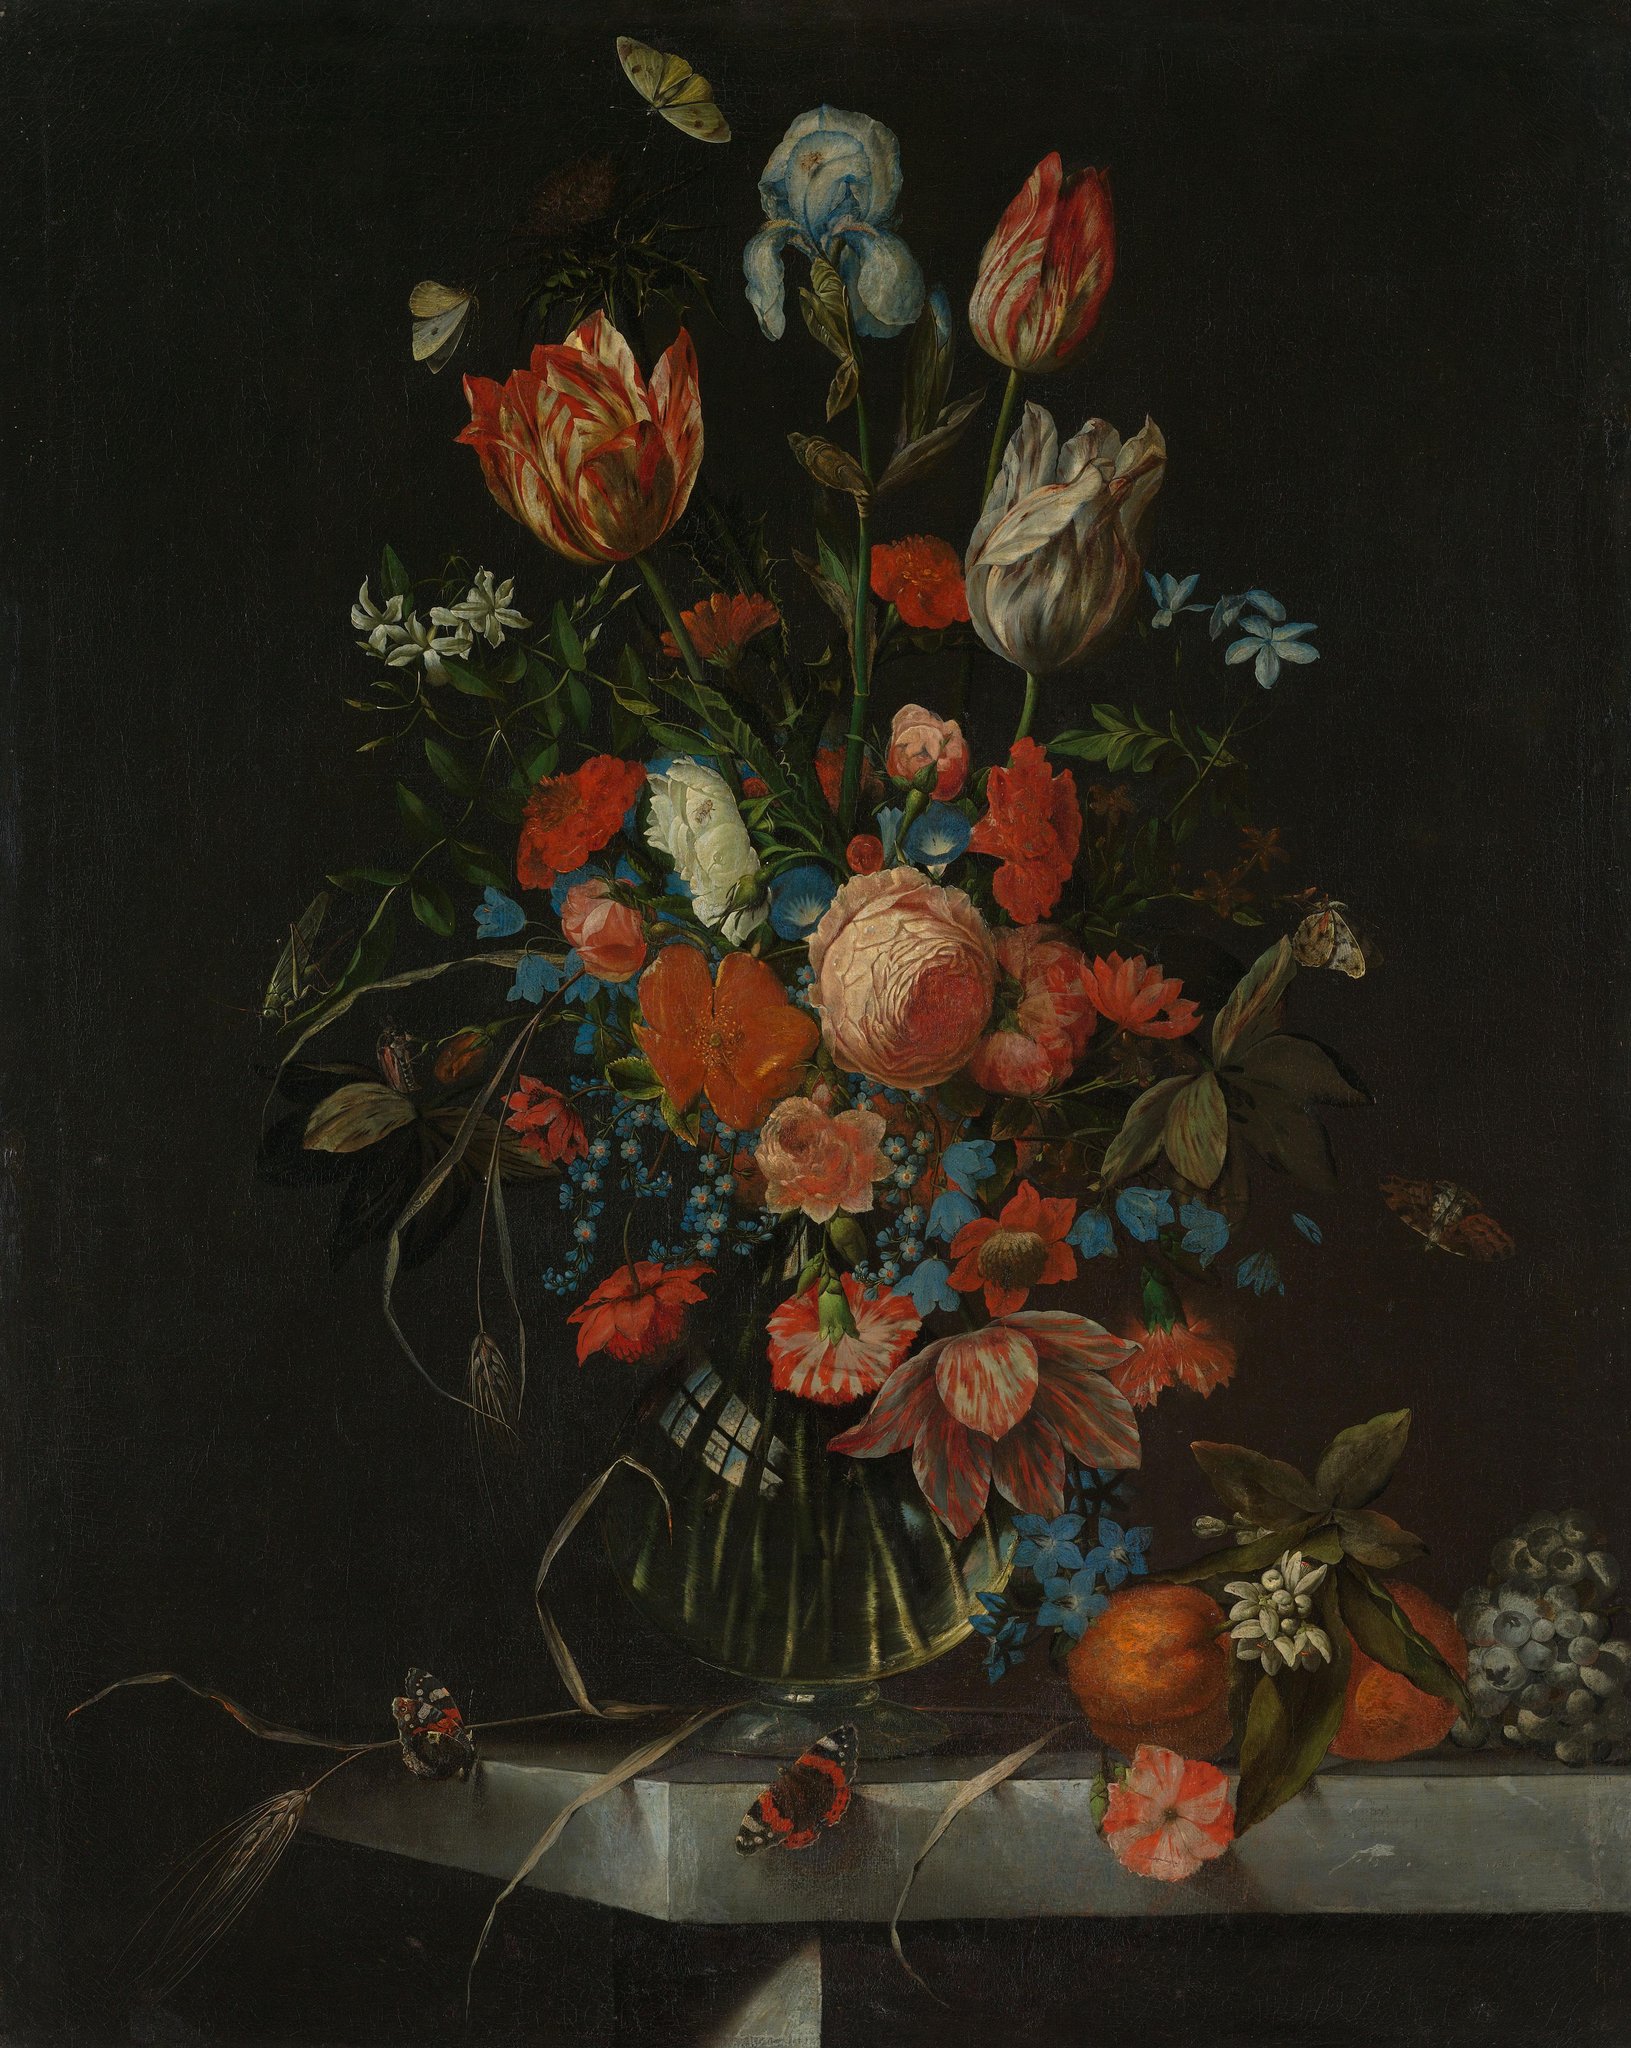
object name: painting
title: Still Life with Flowers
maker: ottmar elliger (i)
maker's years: 1633-1679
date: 1673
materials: canvas, oil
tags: flowers in a vase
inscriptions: signature and date: ‘Ottmar Elliger fecit Anno 1673’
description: Stilleven met bloemen. Boeket van bloemen (rozen, tulpen, irissen) in een glazen vaas op een stenen plint, met vlinders tussen de bloemen.